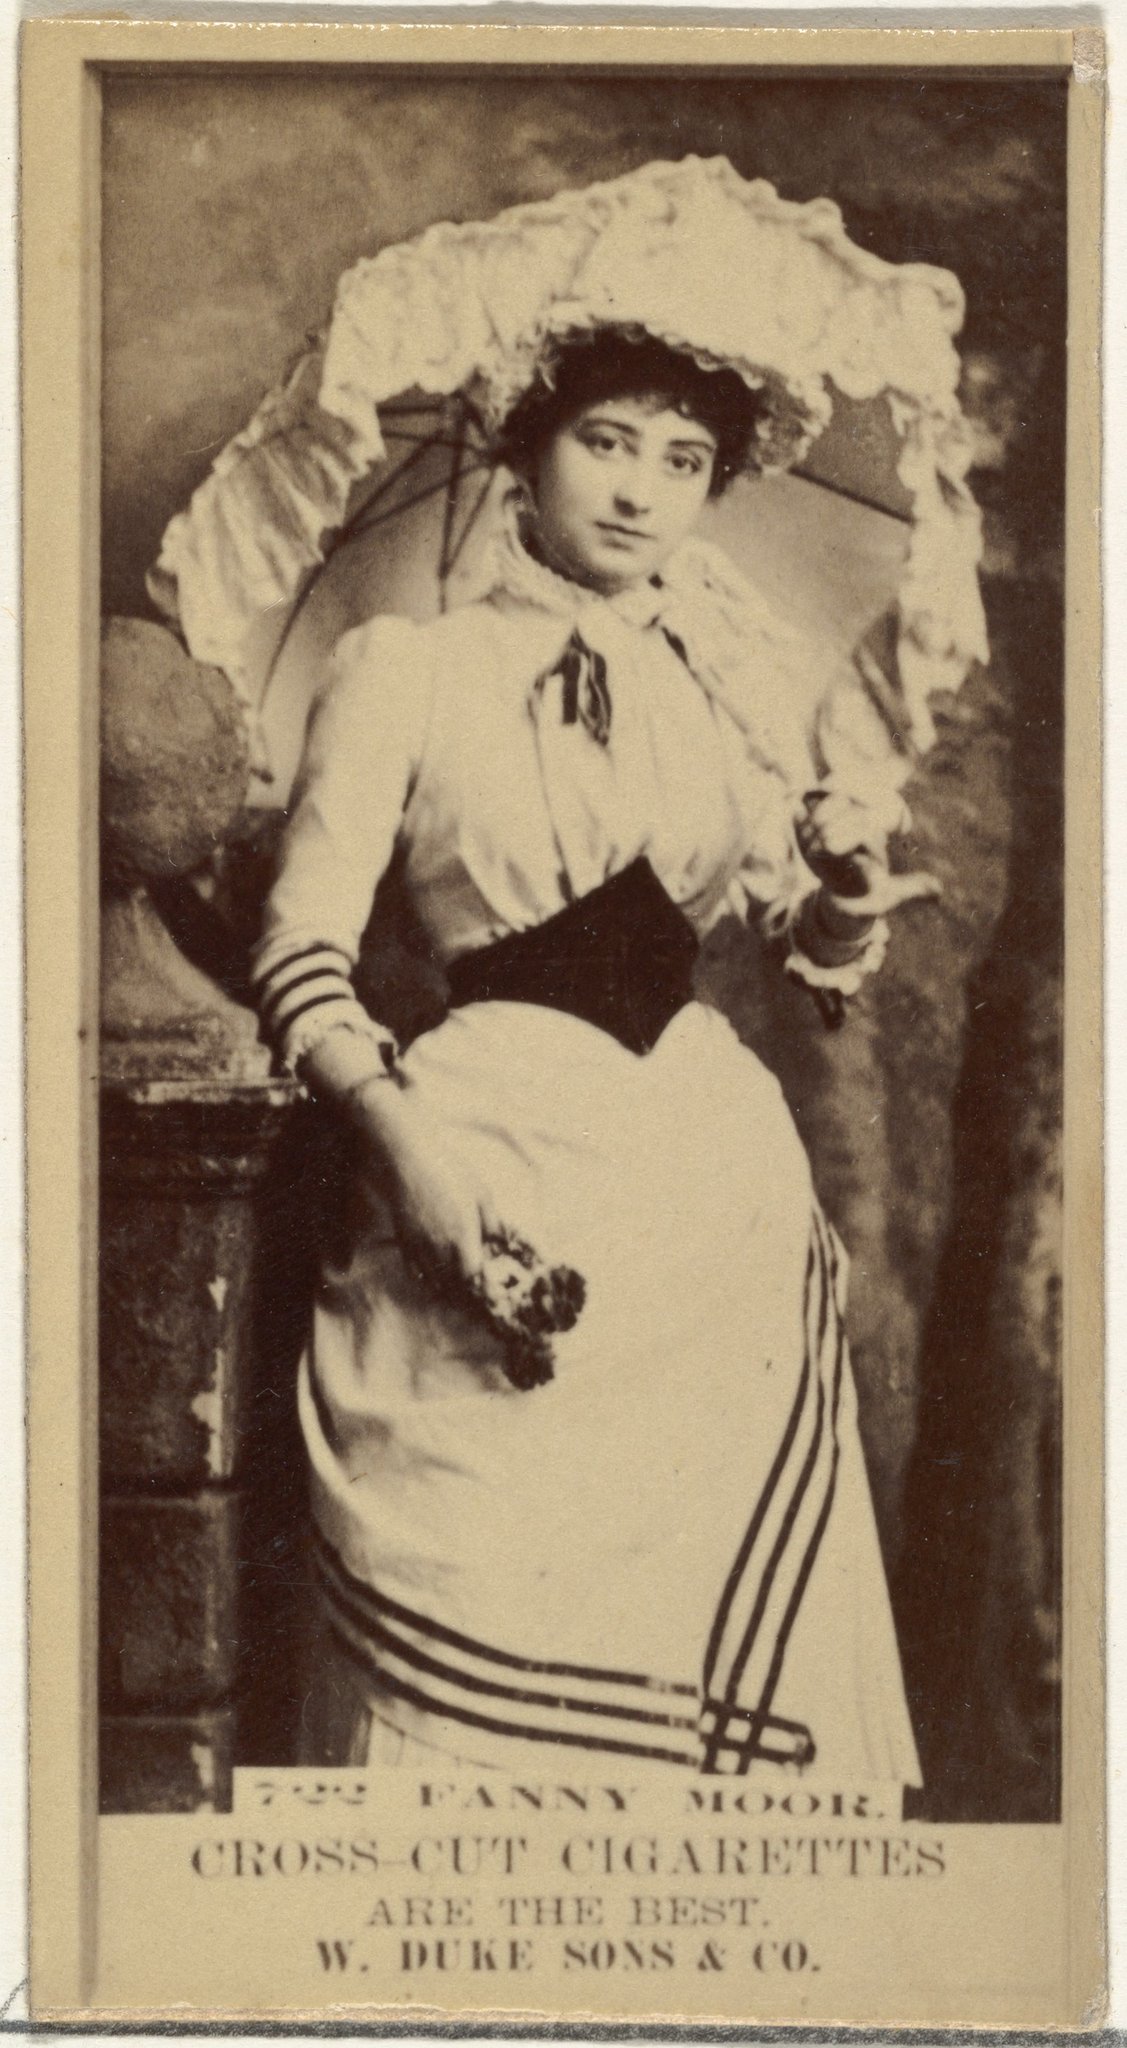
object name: photograph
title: Card Number 722, Fanny Moor, from the Actors and Actresses series (N145-3) issued by Duke Sons & Co. to promote Cross Cut Cigarettes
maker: w. duke, sons & co.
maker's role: publisher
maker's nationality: american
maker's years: 1870-1920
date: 1880-1889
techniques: albumen silver print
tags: portraits,women,actresses